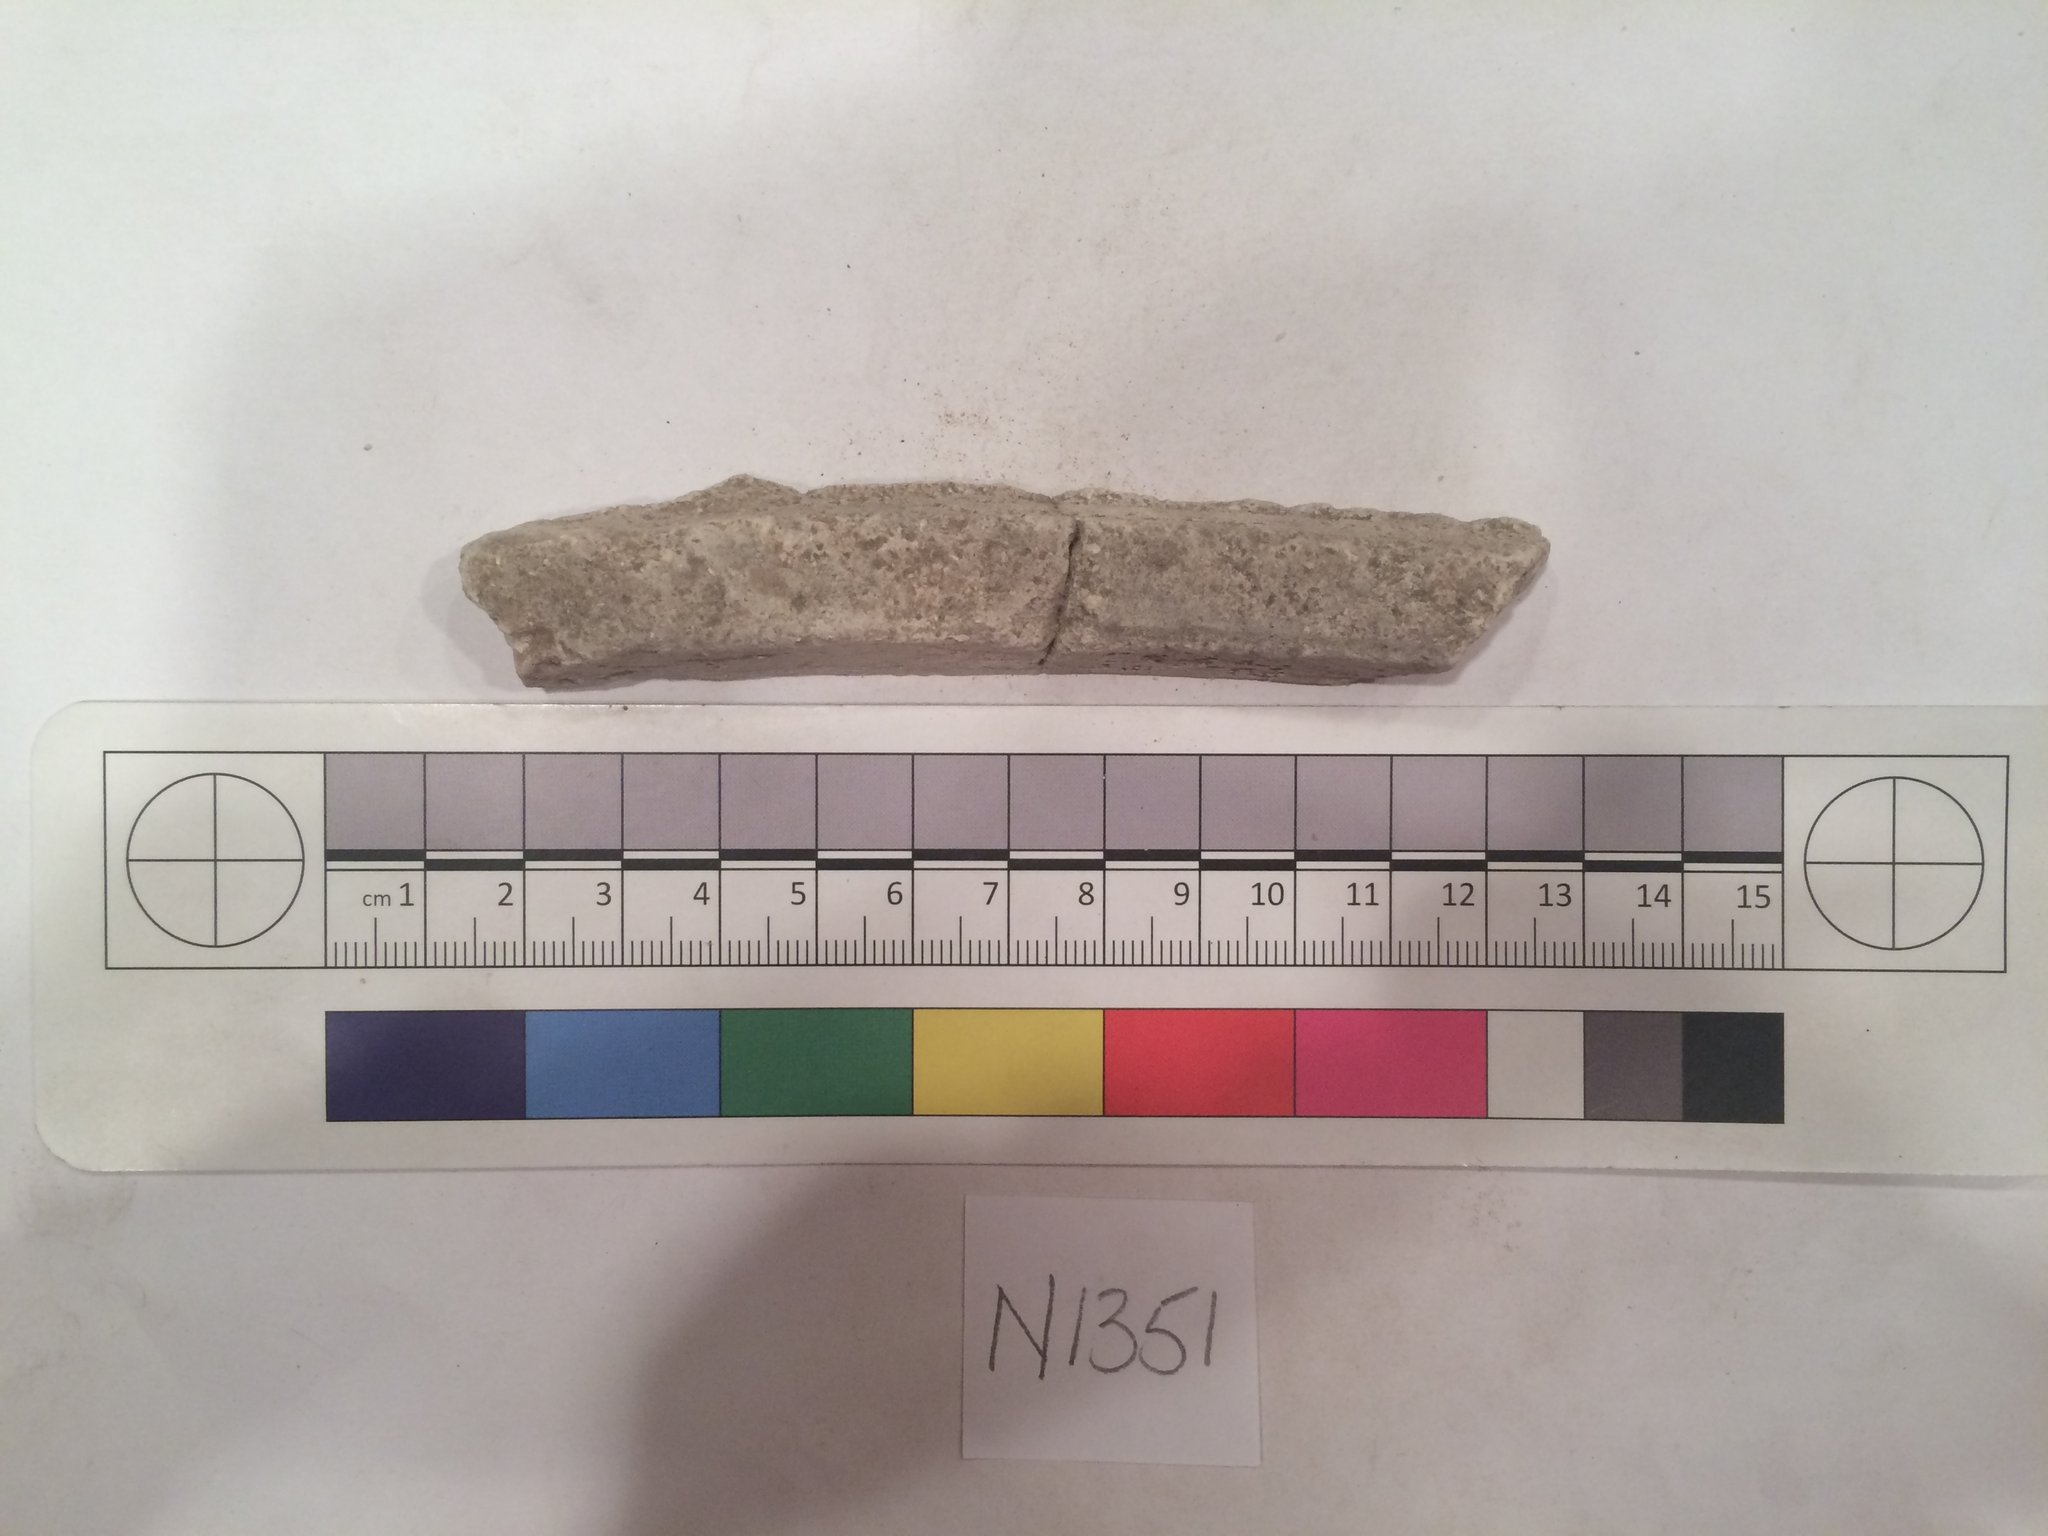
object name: fragment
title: Stucco Fragment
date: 701-1200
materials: plaster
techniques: carving, painting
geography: iran